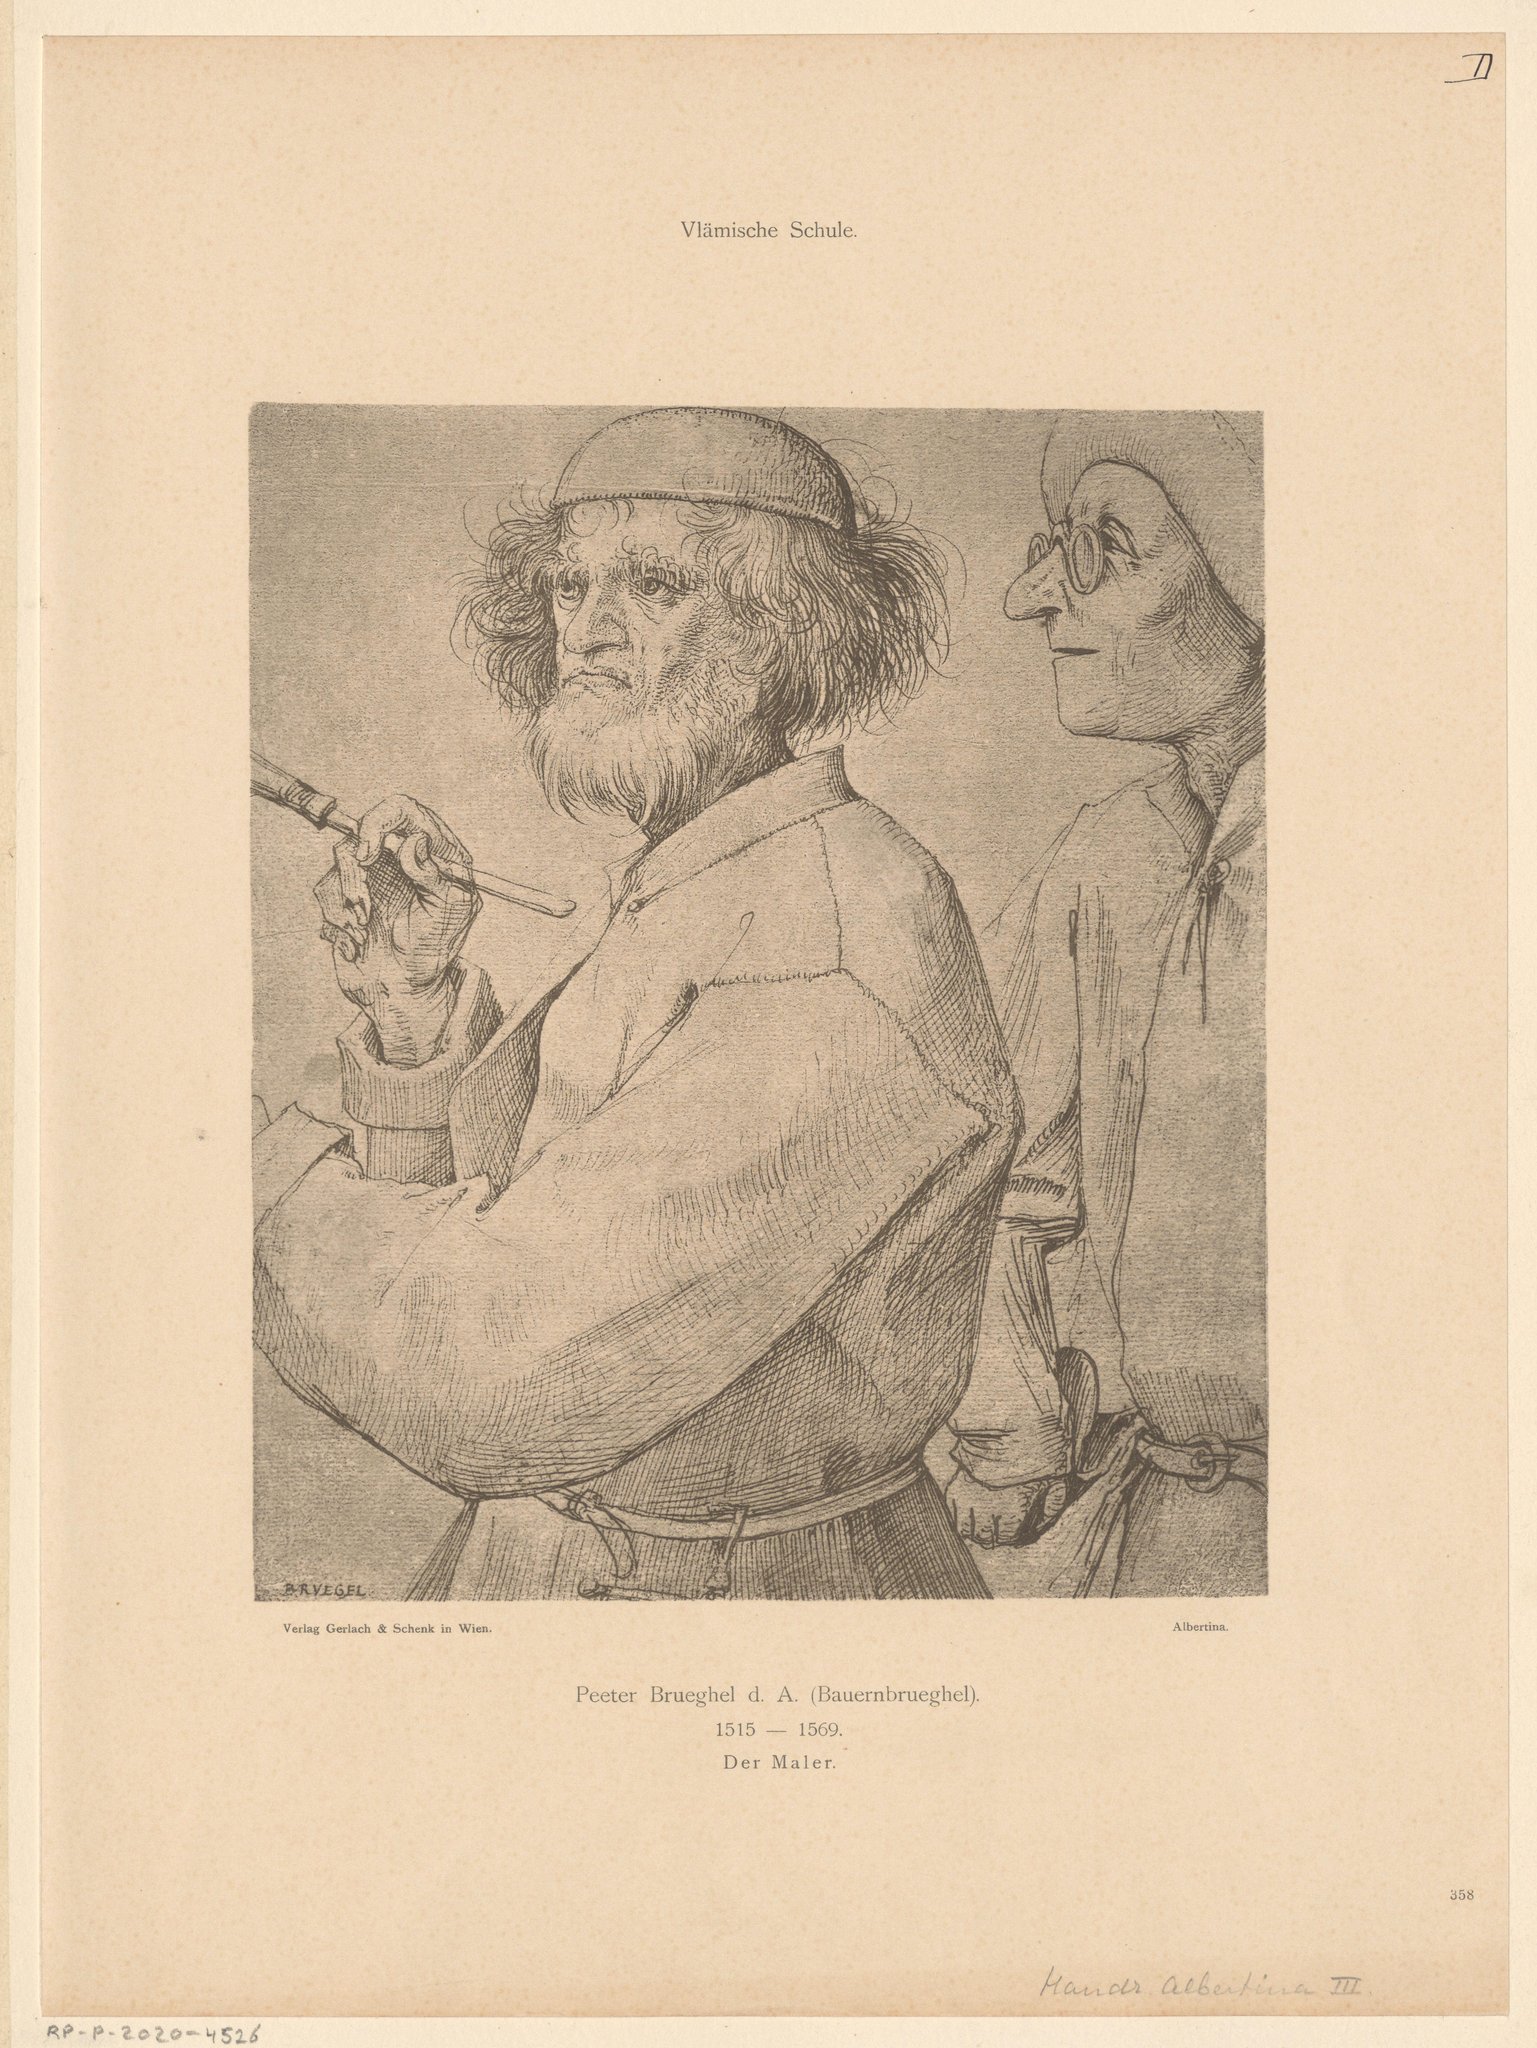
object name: photomechanical print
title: Schilder en koopman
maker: Anonymous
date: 1882-1901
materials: paper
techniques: photograph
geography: vienna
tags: portrait, self-portrait of painter, merchant, salesman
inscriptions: collector's mark: Lugt 2228